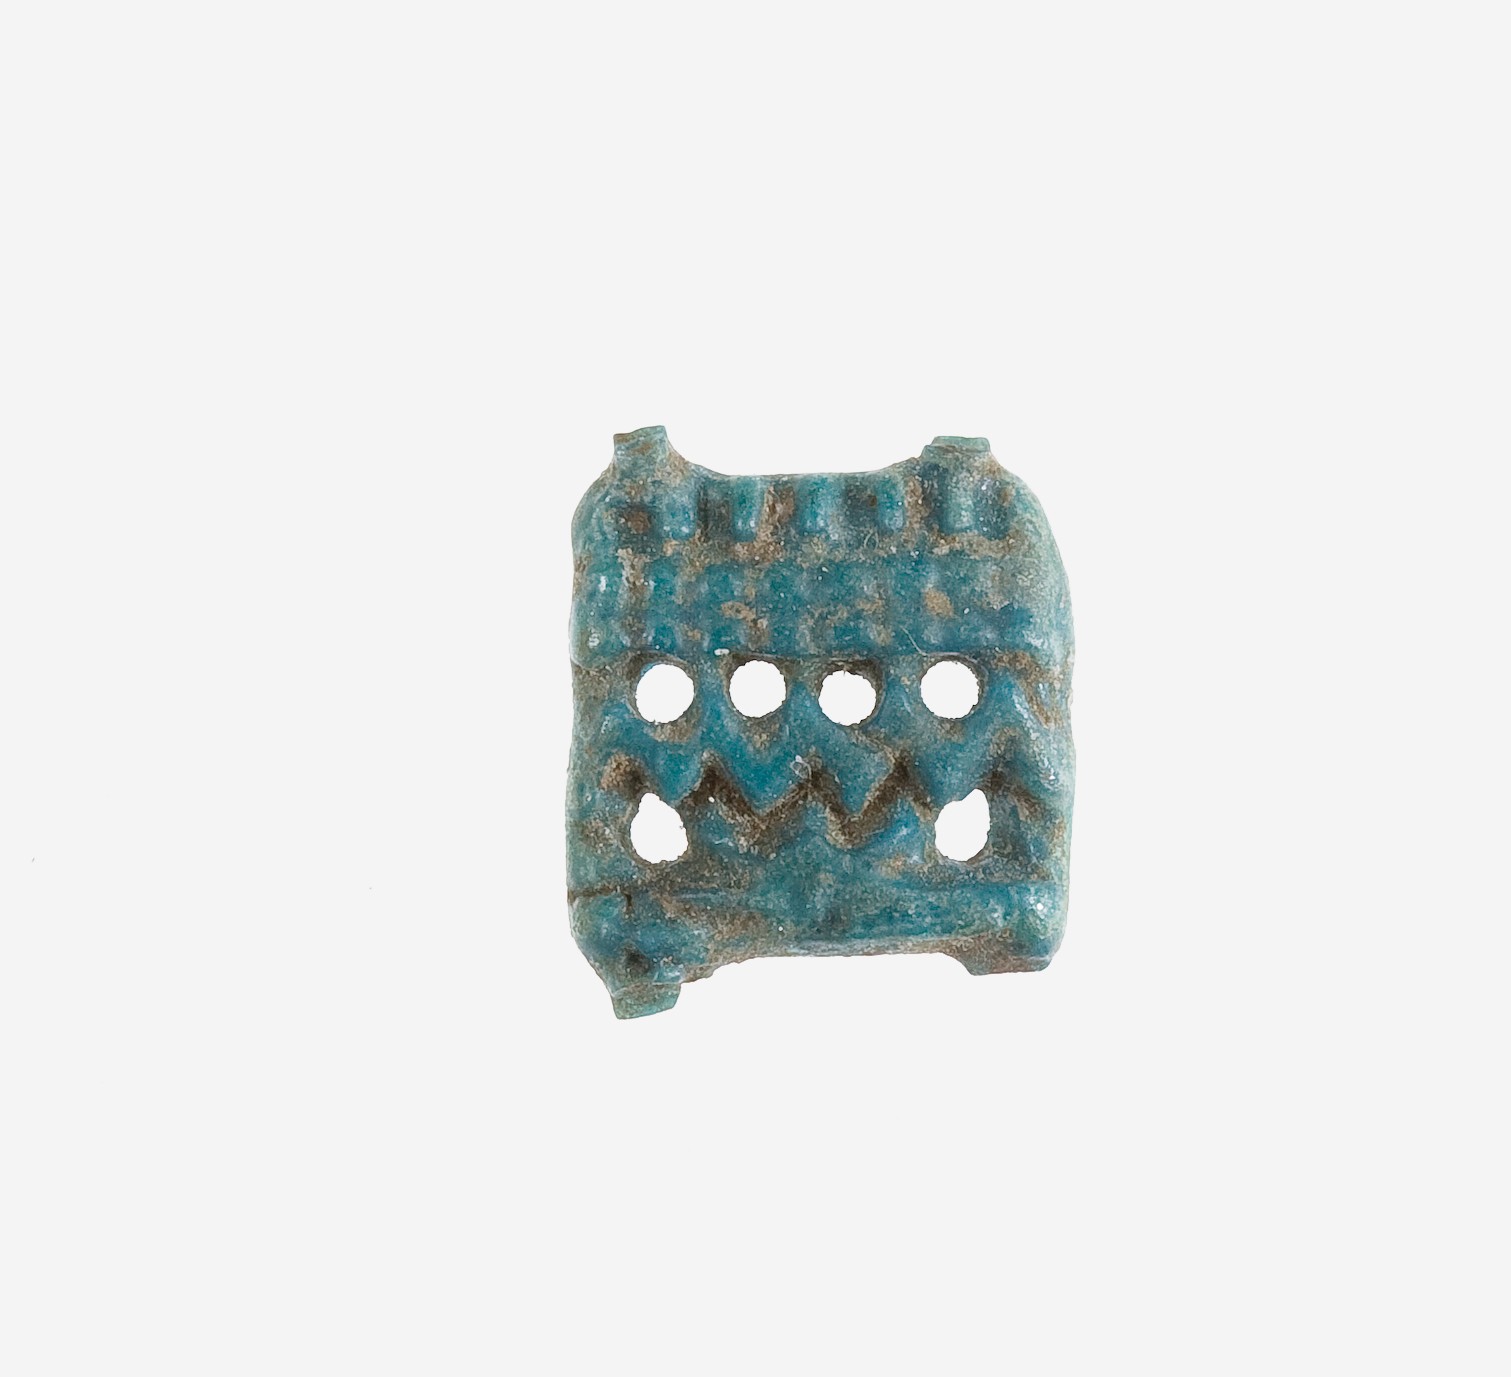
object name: amulet, establish, mn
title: Amulet of the Word "Establish"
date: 1390-1352 BCE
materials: faience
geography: egypt